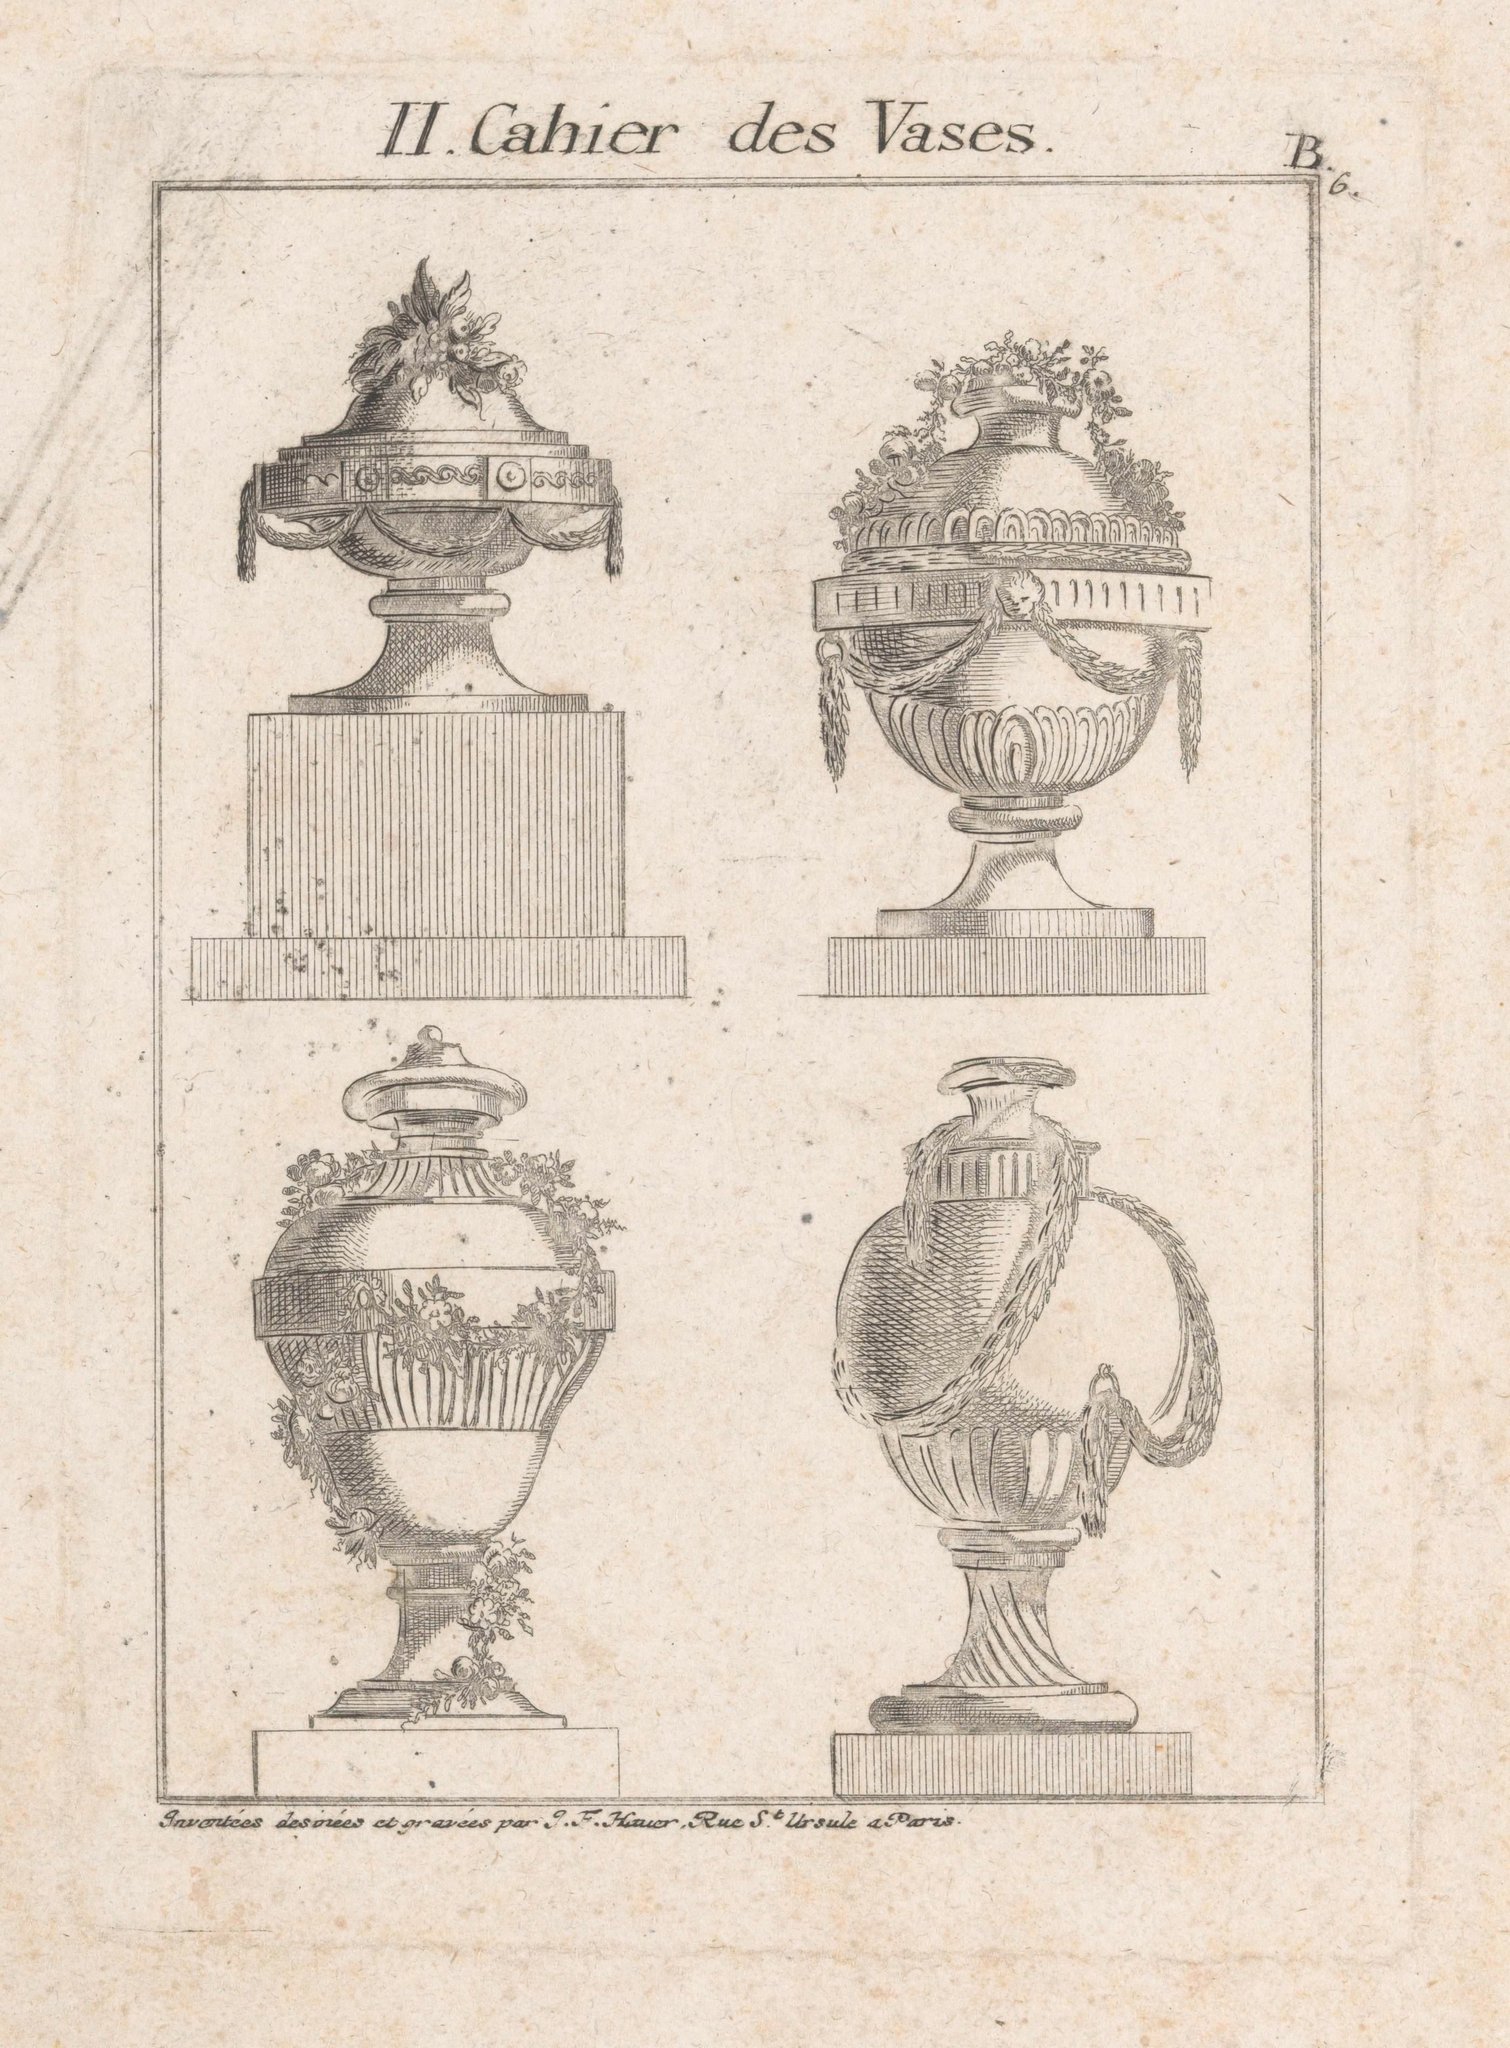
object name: print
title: II Cahier des Vases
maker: johann thomas hauer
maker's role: print maker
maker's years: 1748-1820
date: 1758-1820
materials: paper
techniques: engraving, etching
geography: paris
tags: vase ~ ornament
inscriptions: collector's mark: Lugt 2228, collector's mark: Lugt 2760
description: Ontwerpen voor vier vazen met bloemen en guirlandes.